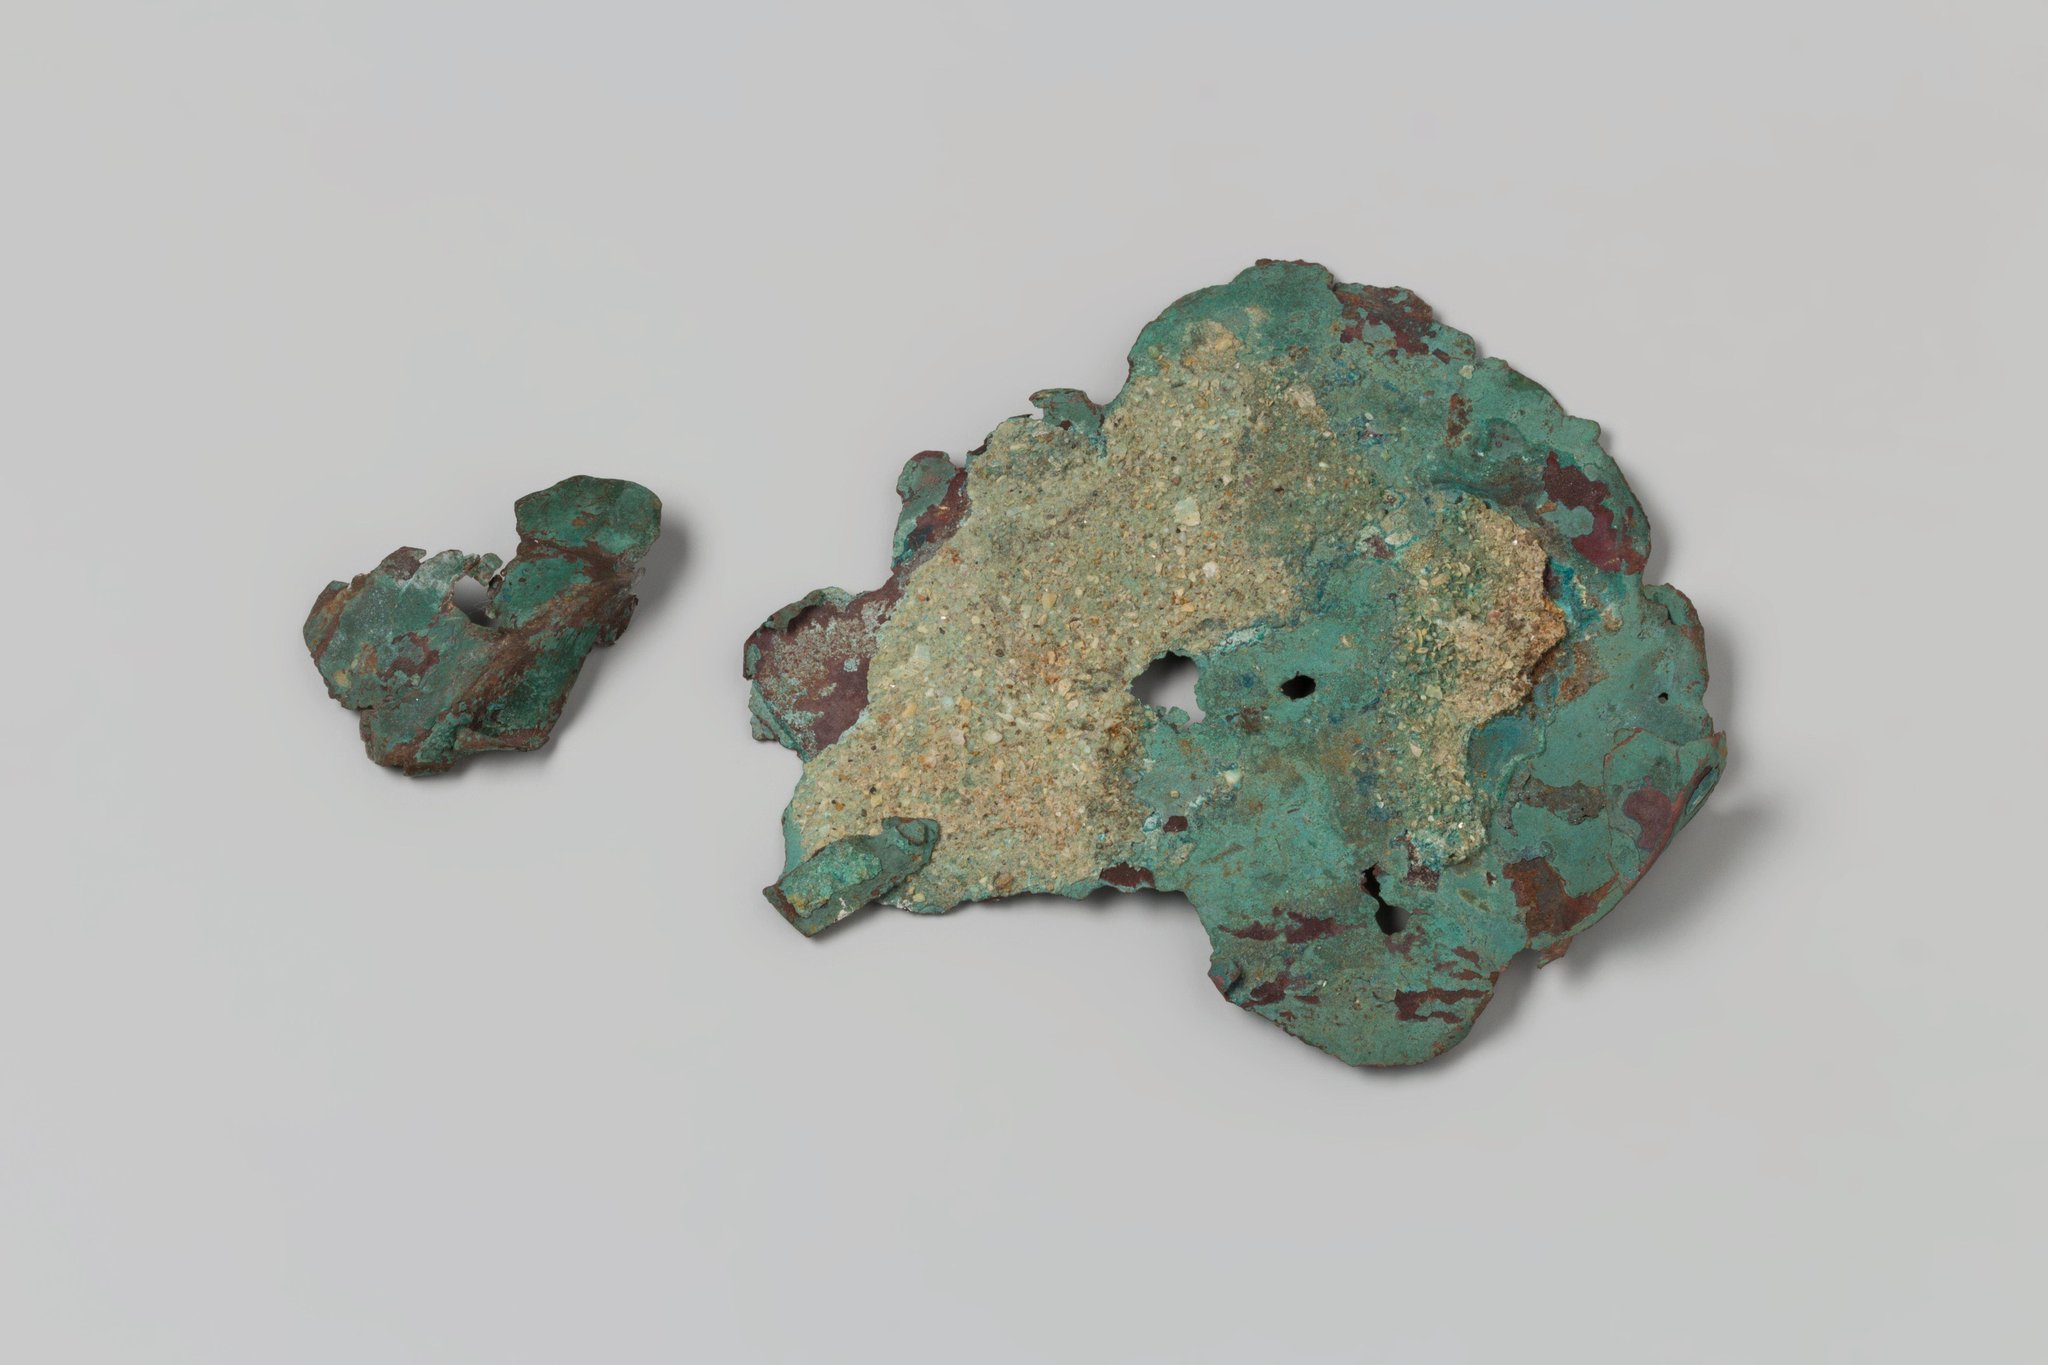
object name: scheepswrakvondst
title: Fragmenten van koper uit het wrak van de Oost-Indiëvaarder Hollandia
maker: Anonymous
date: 1700-1743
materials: copper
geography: netherlands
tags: verenigde oostindische compagnie, hollandia (schip), annet